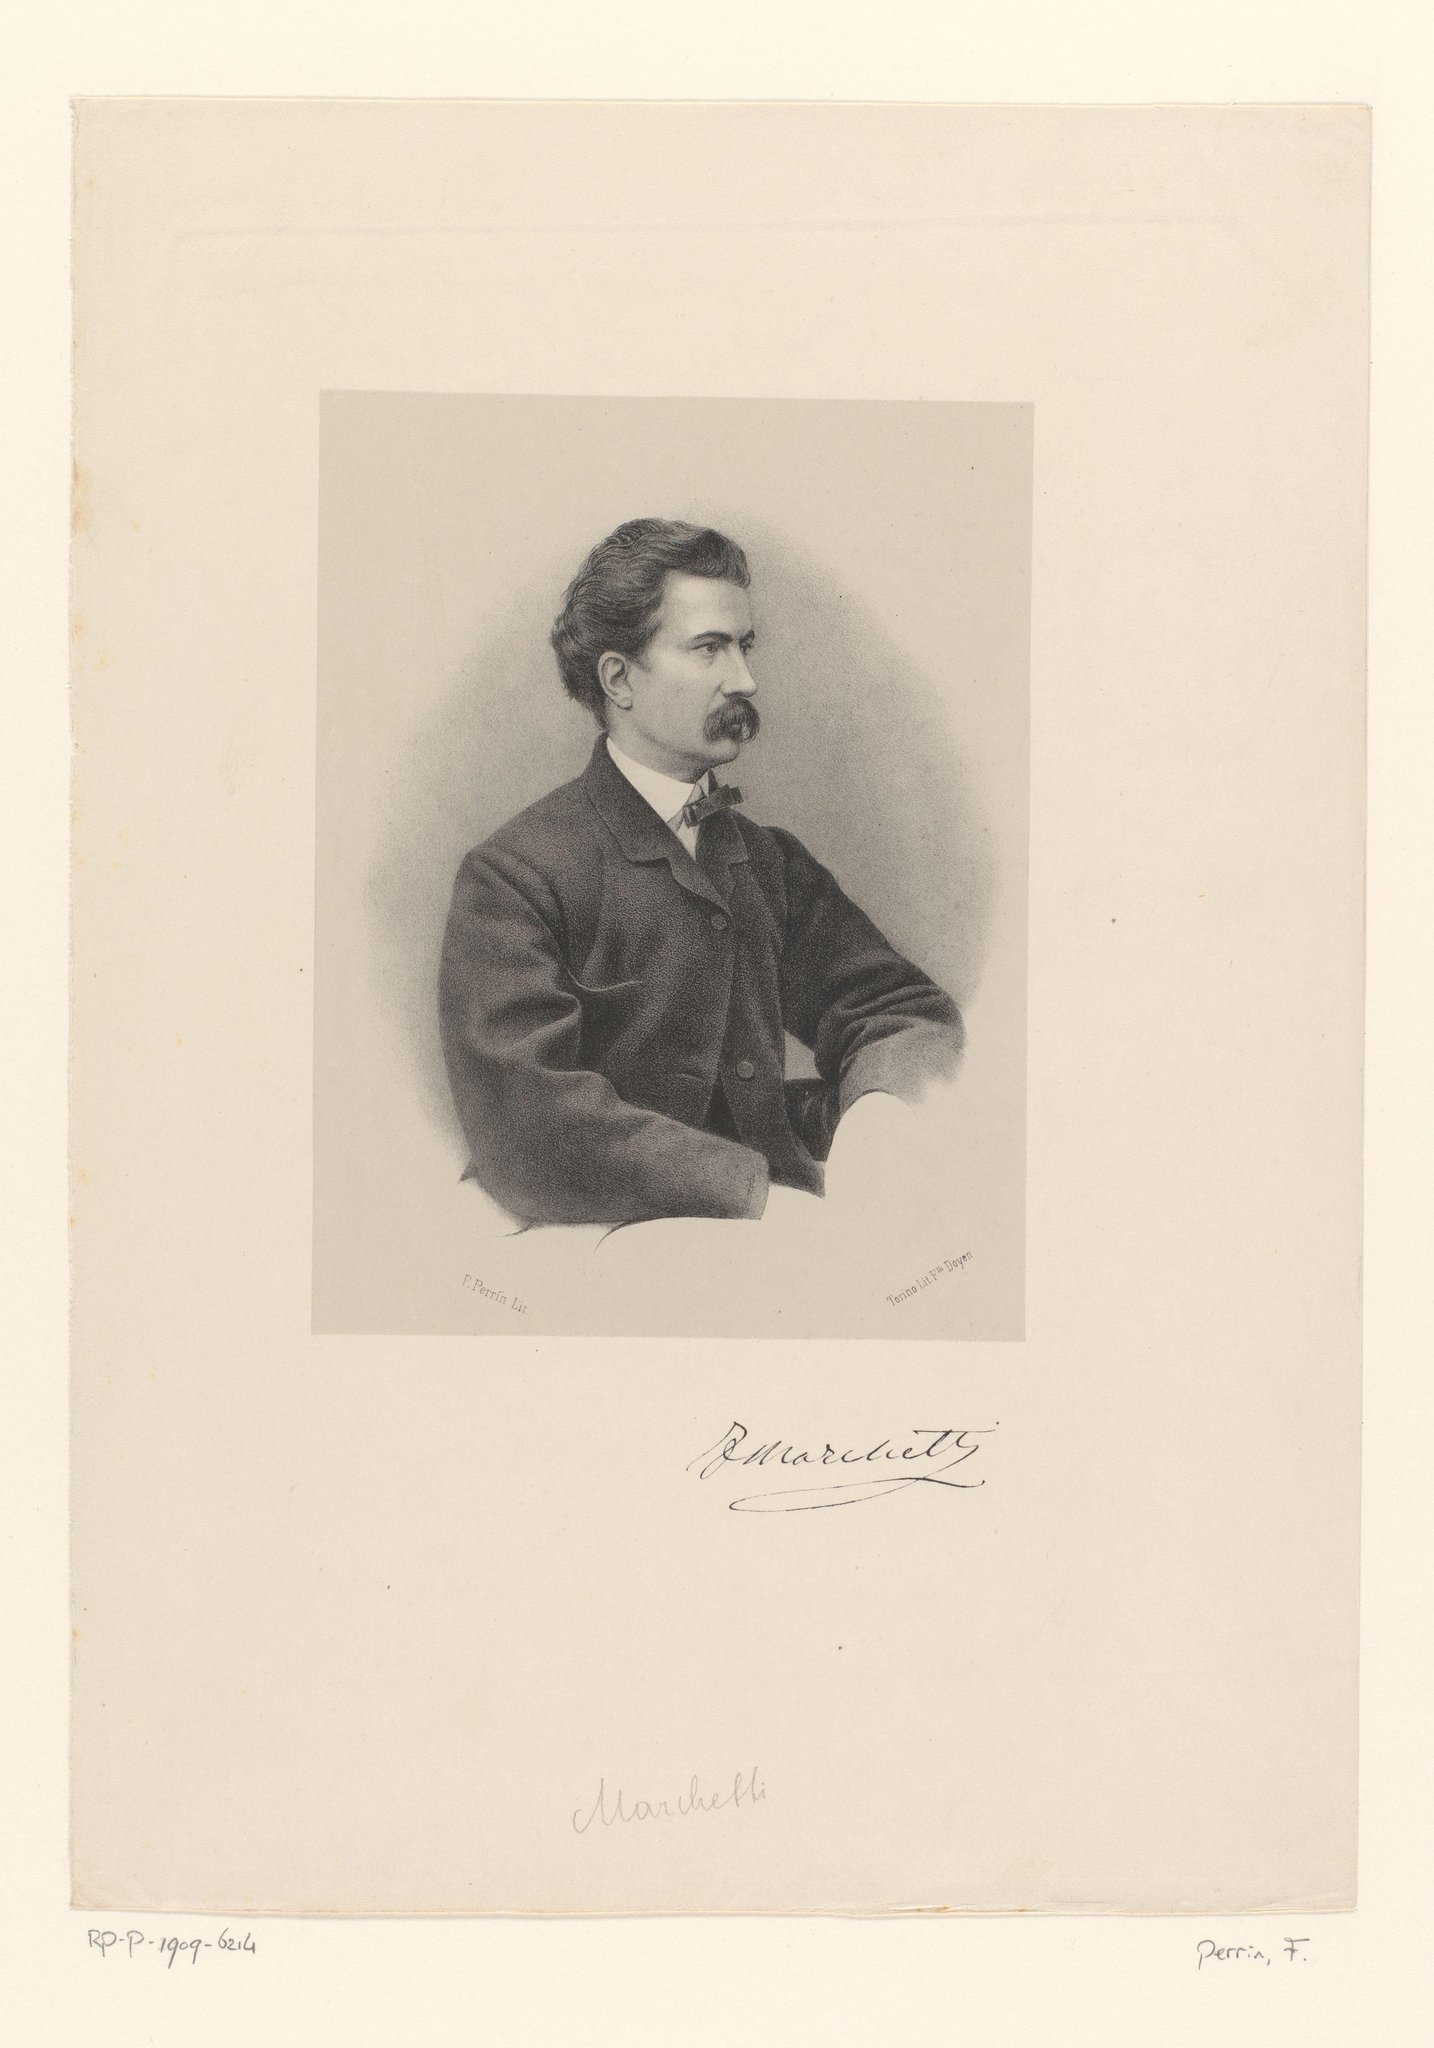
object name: print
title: Portret van de heer Marchetti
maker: f. perrin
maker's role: print maker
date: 1800-1899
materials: paper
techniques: lithograph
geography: italy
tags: historical persons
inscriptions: collector's mark: Lugt 2228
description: De prent is voorzien van een imitatieplaatrand.